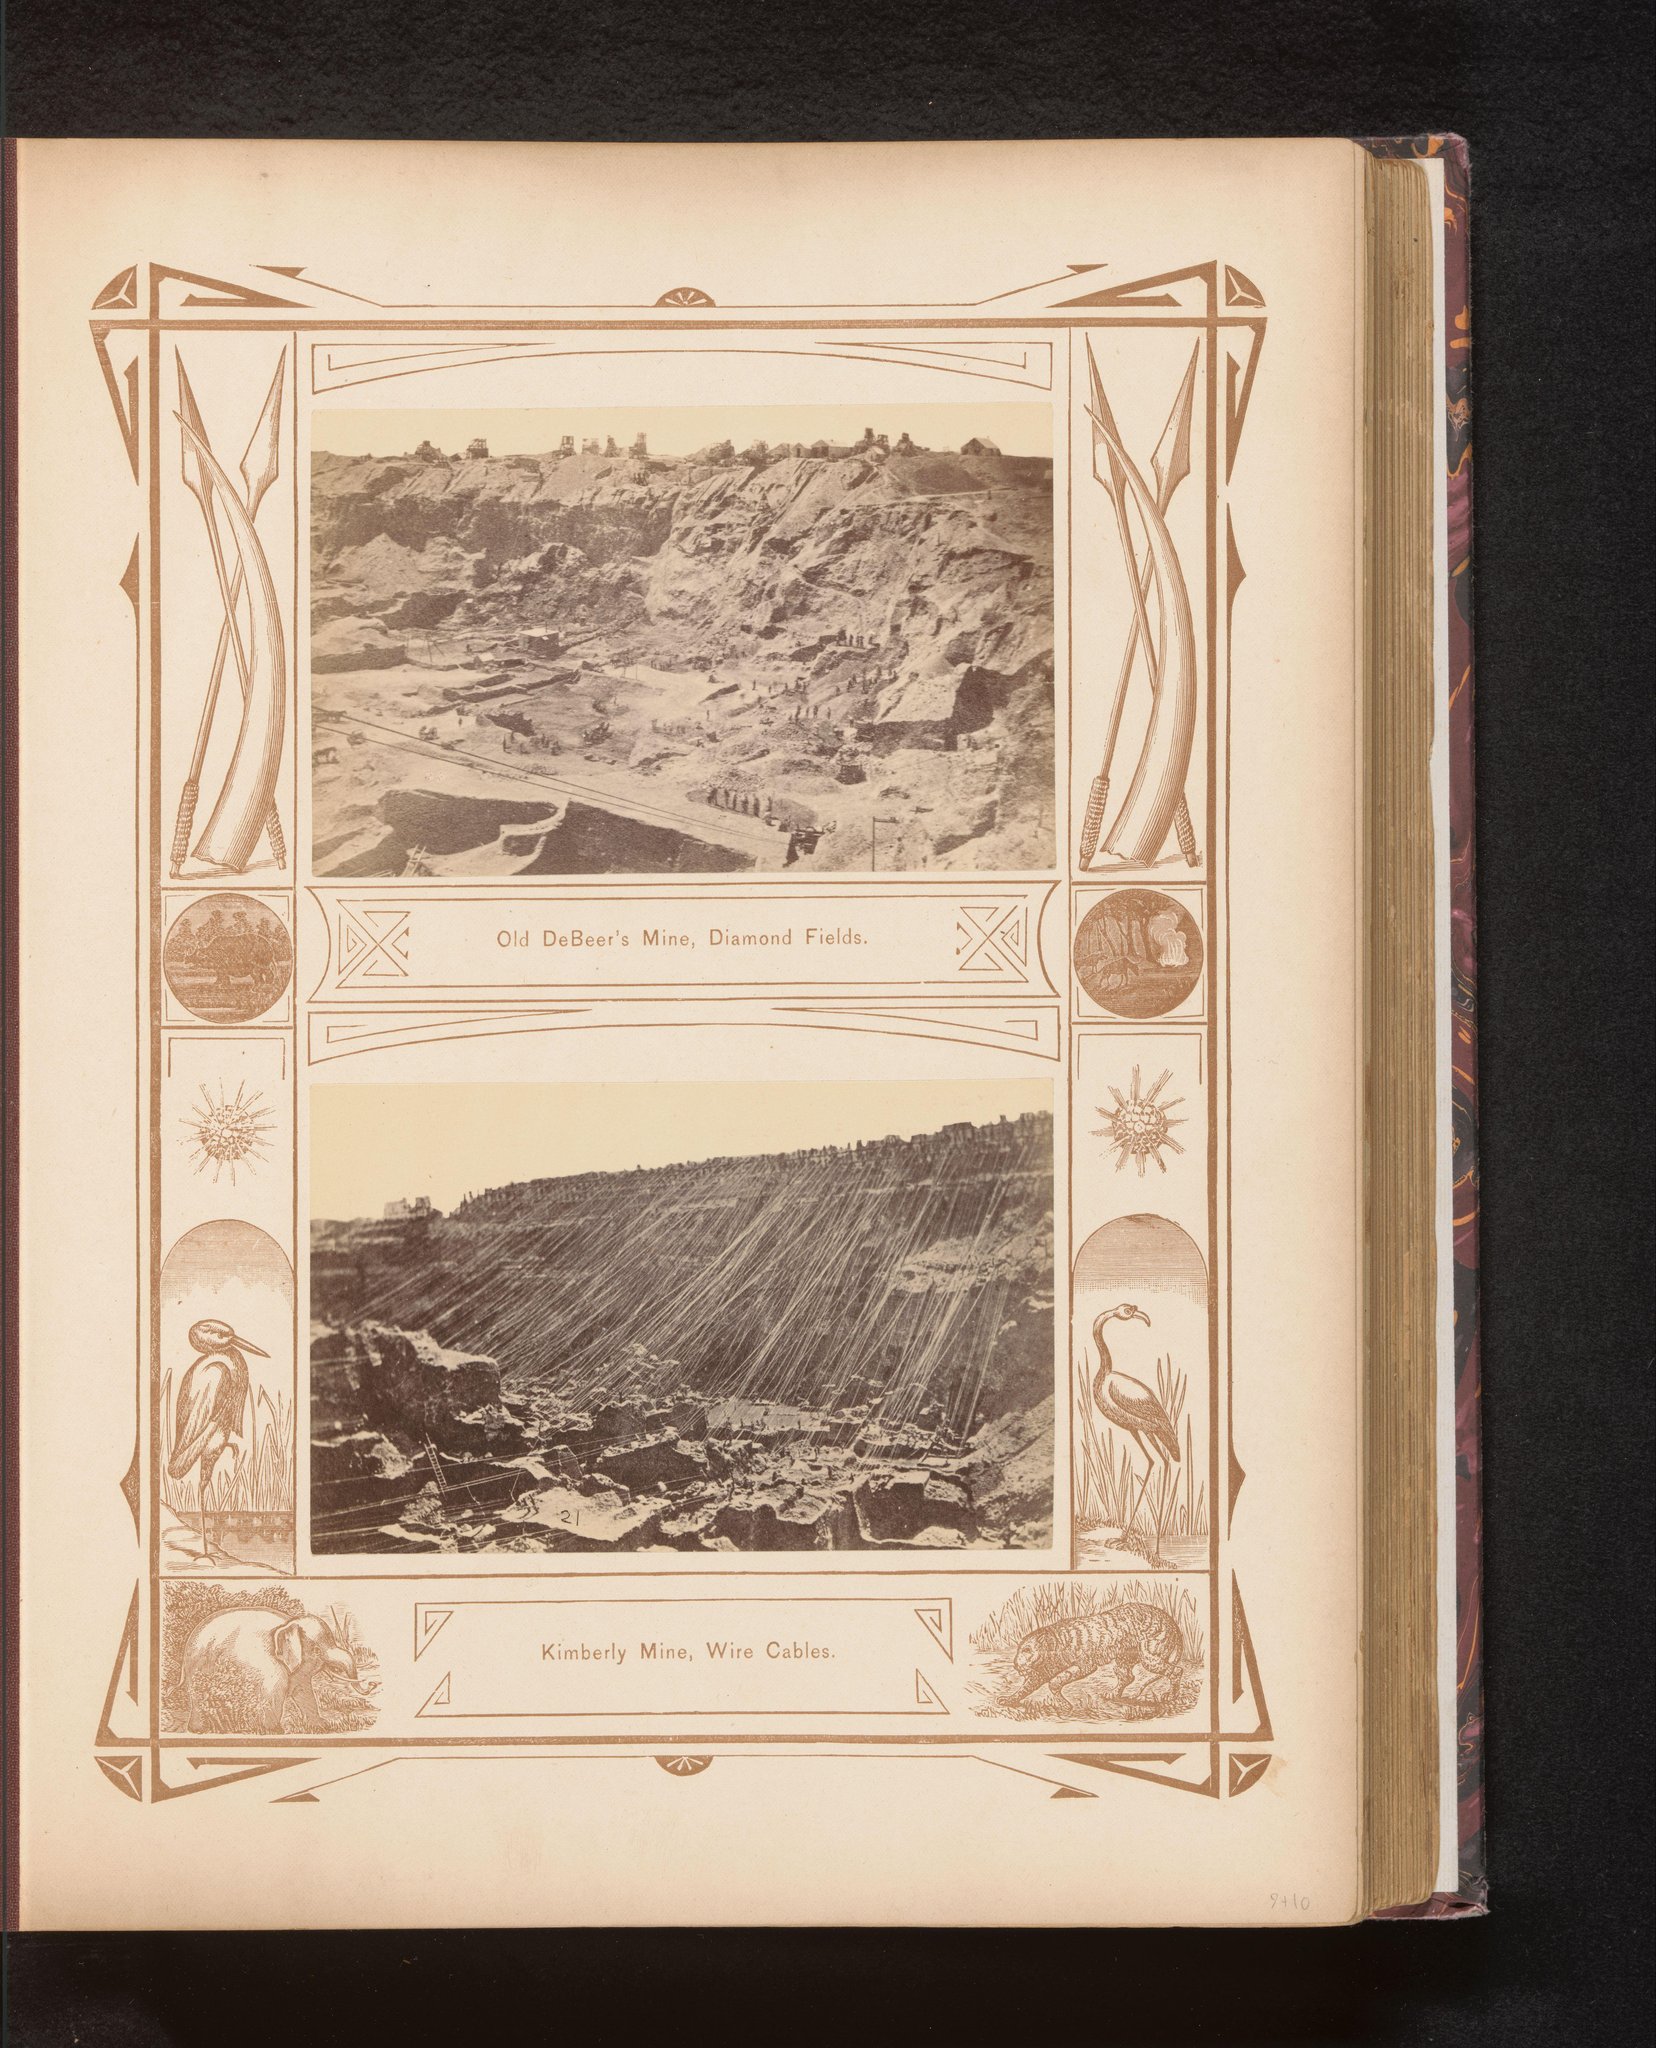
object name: photograph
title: Kabels bij de Kimberly mijn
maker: Anonymous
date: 1877-1882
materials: photographic support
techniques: albumen print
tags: mine